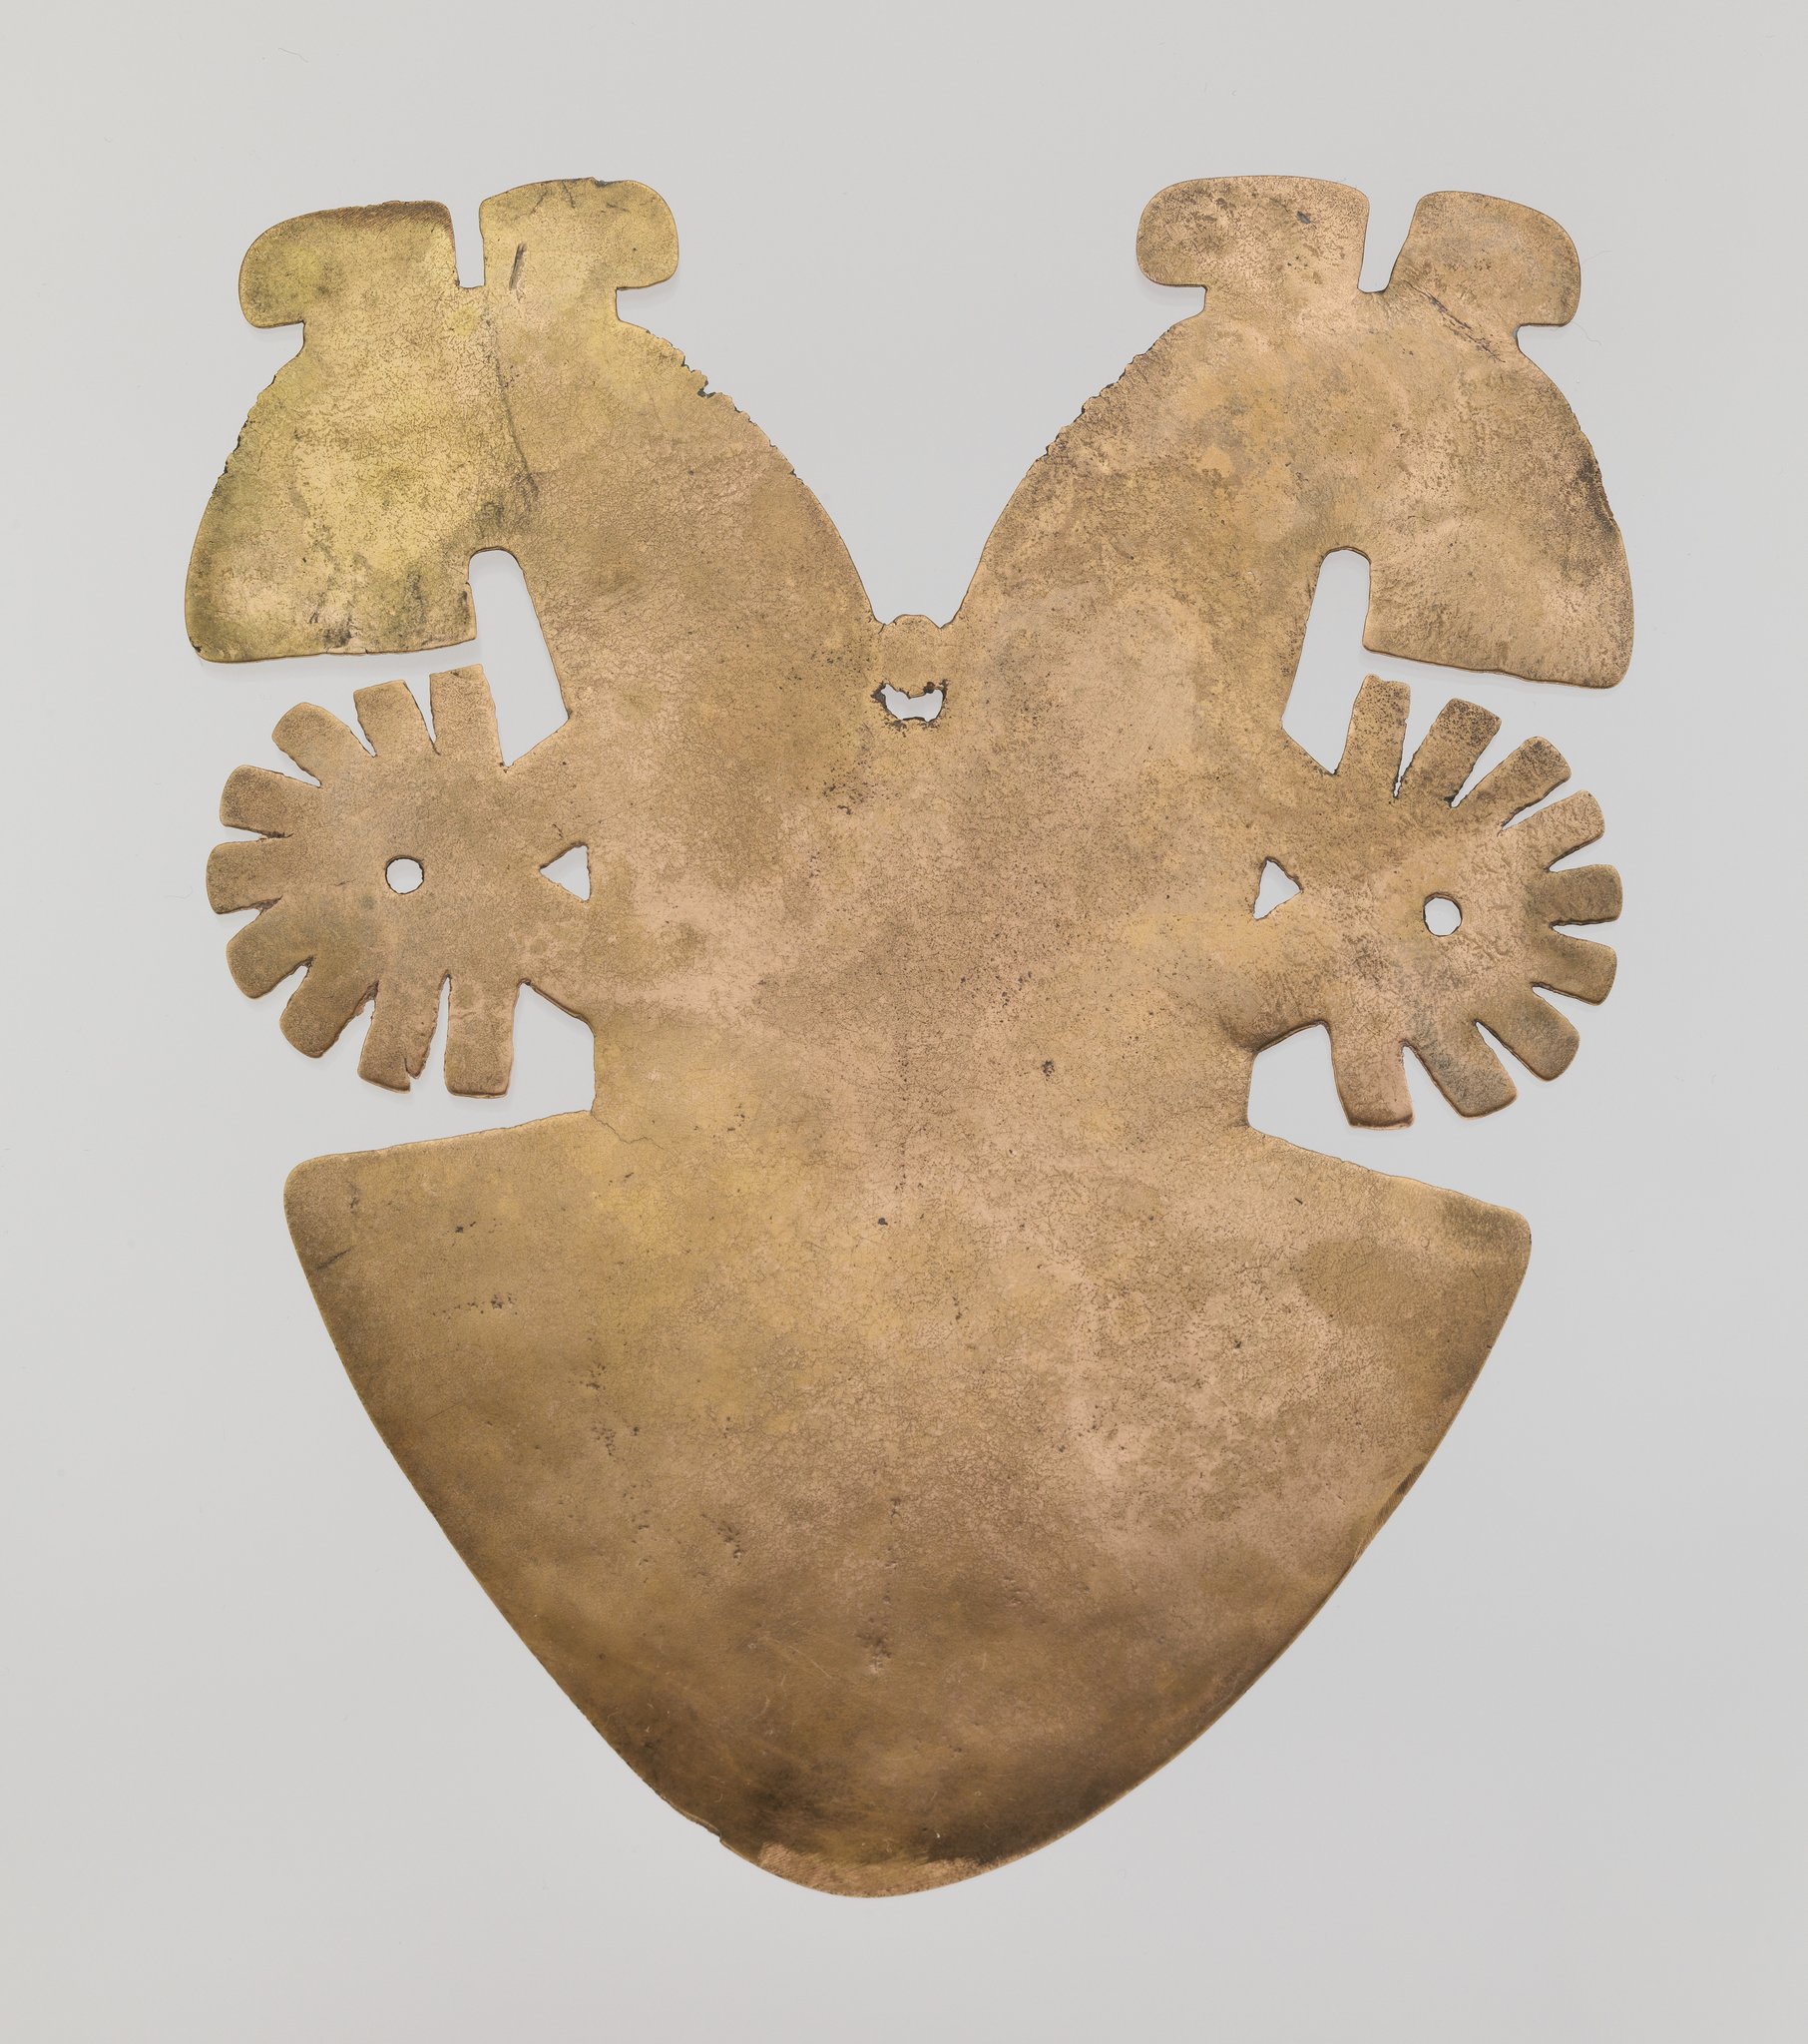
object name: pendant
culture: sonso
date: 1201-1600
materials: gold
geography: colombia